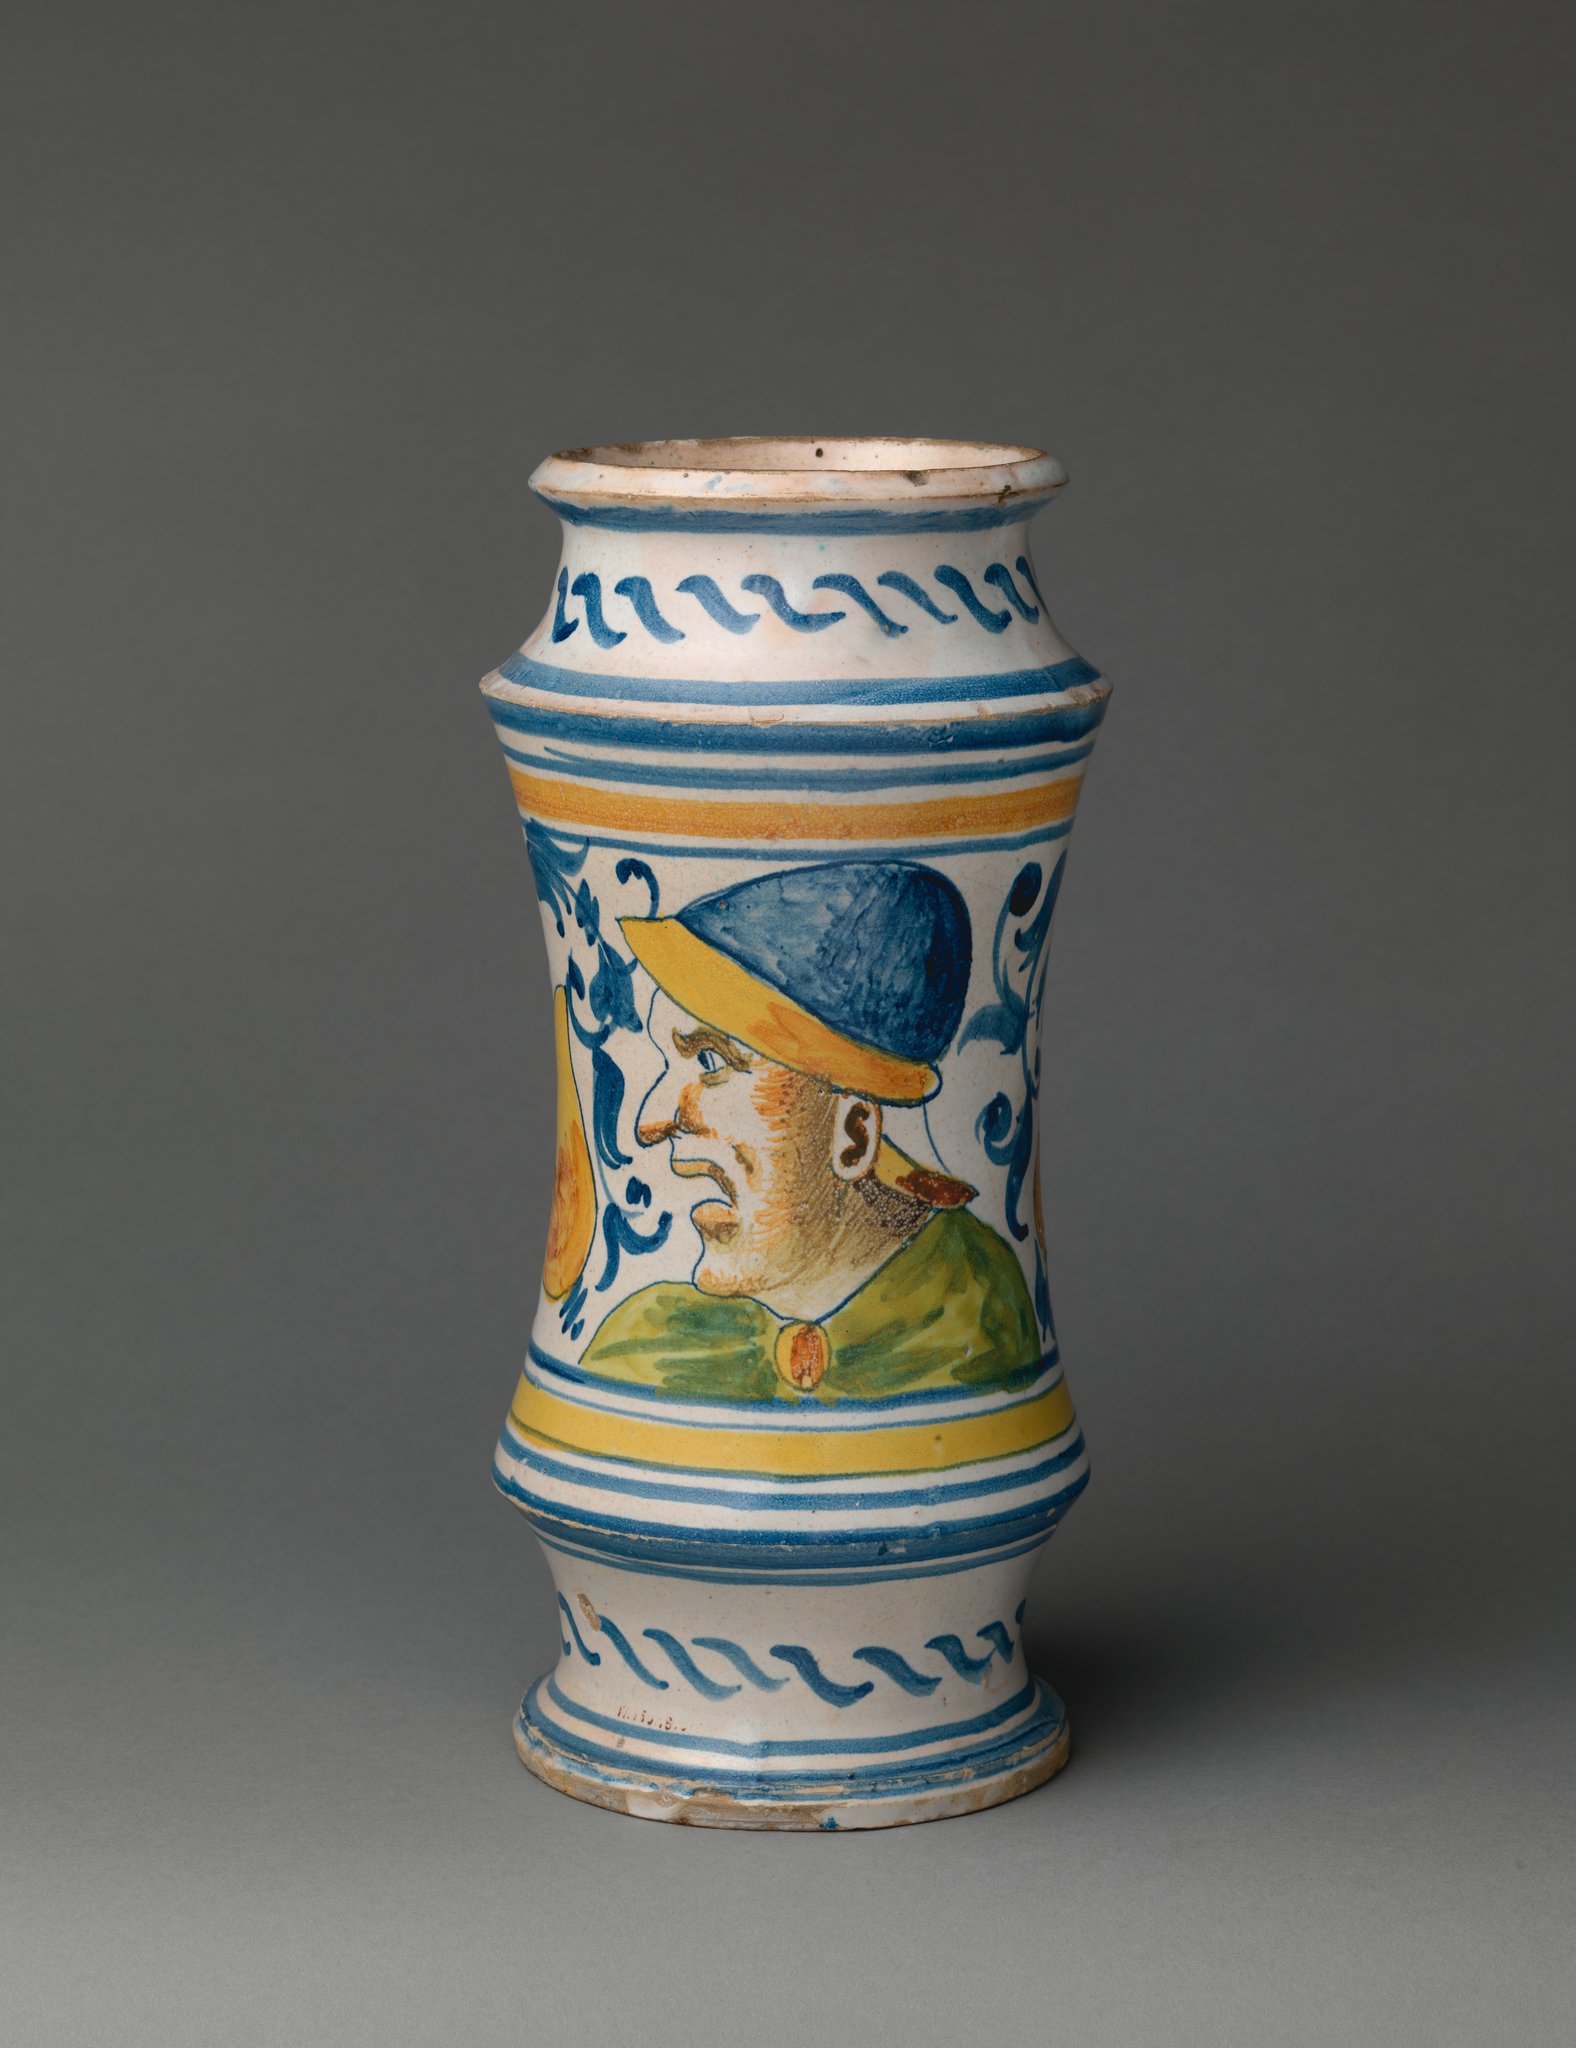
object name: pharmacy jar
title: Pharmacy jar (albarello)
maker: masséot abaquesne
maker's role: maker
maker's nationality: french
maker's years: 1538-1557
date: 1545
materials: earthenware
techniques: glazing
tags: men,profiles